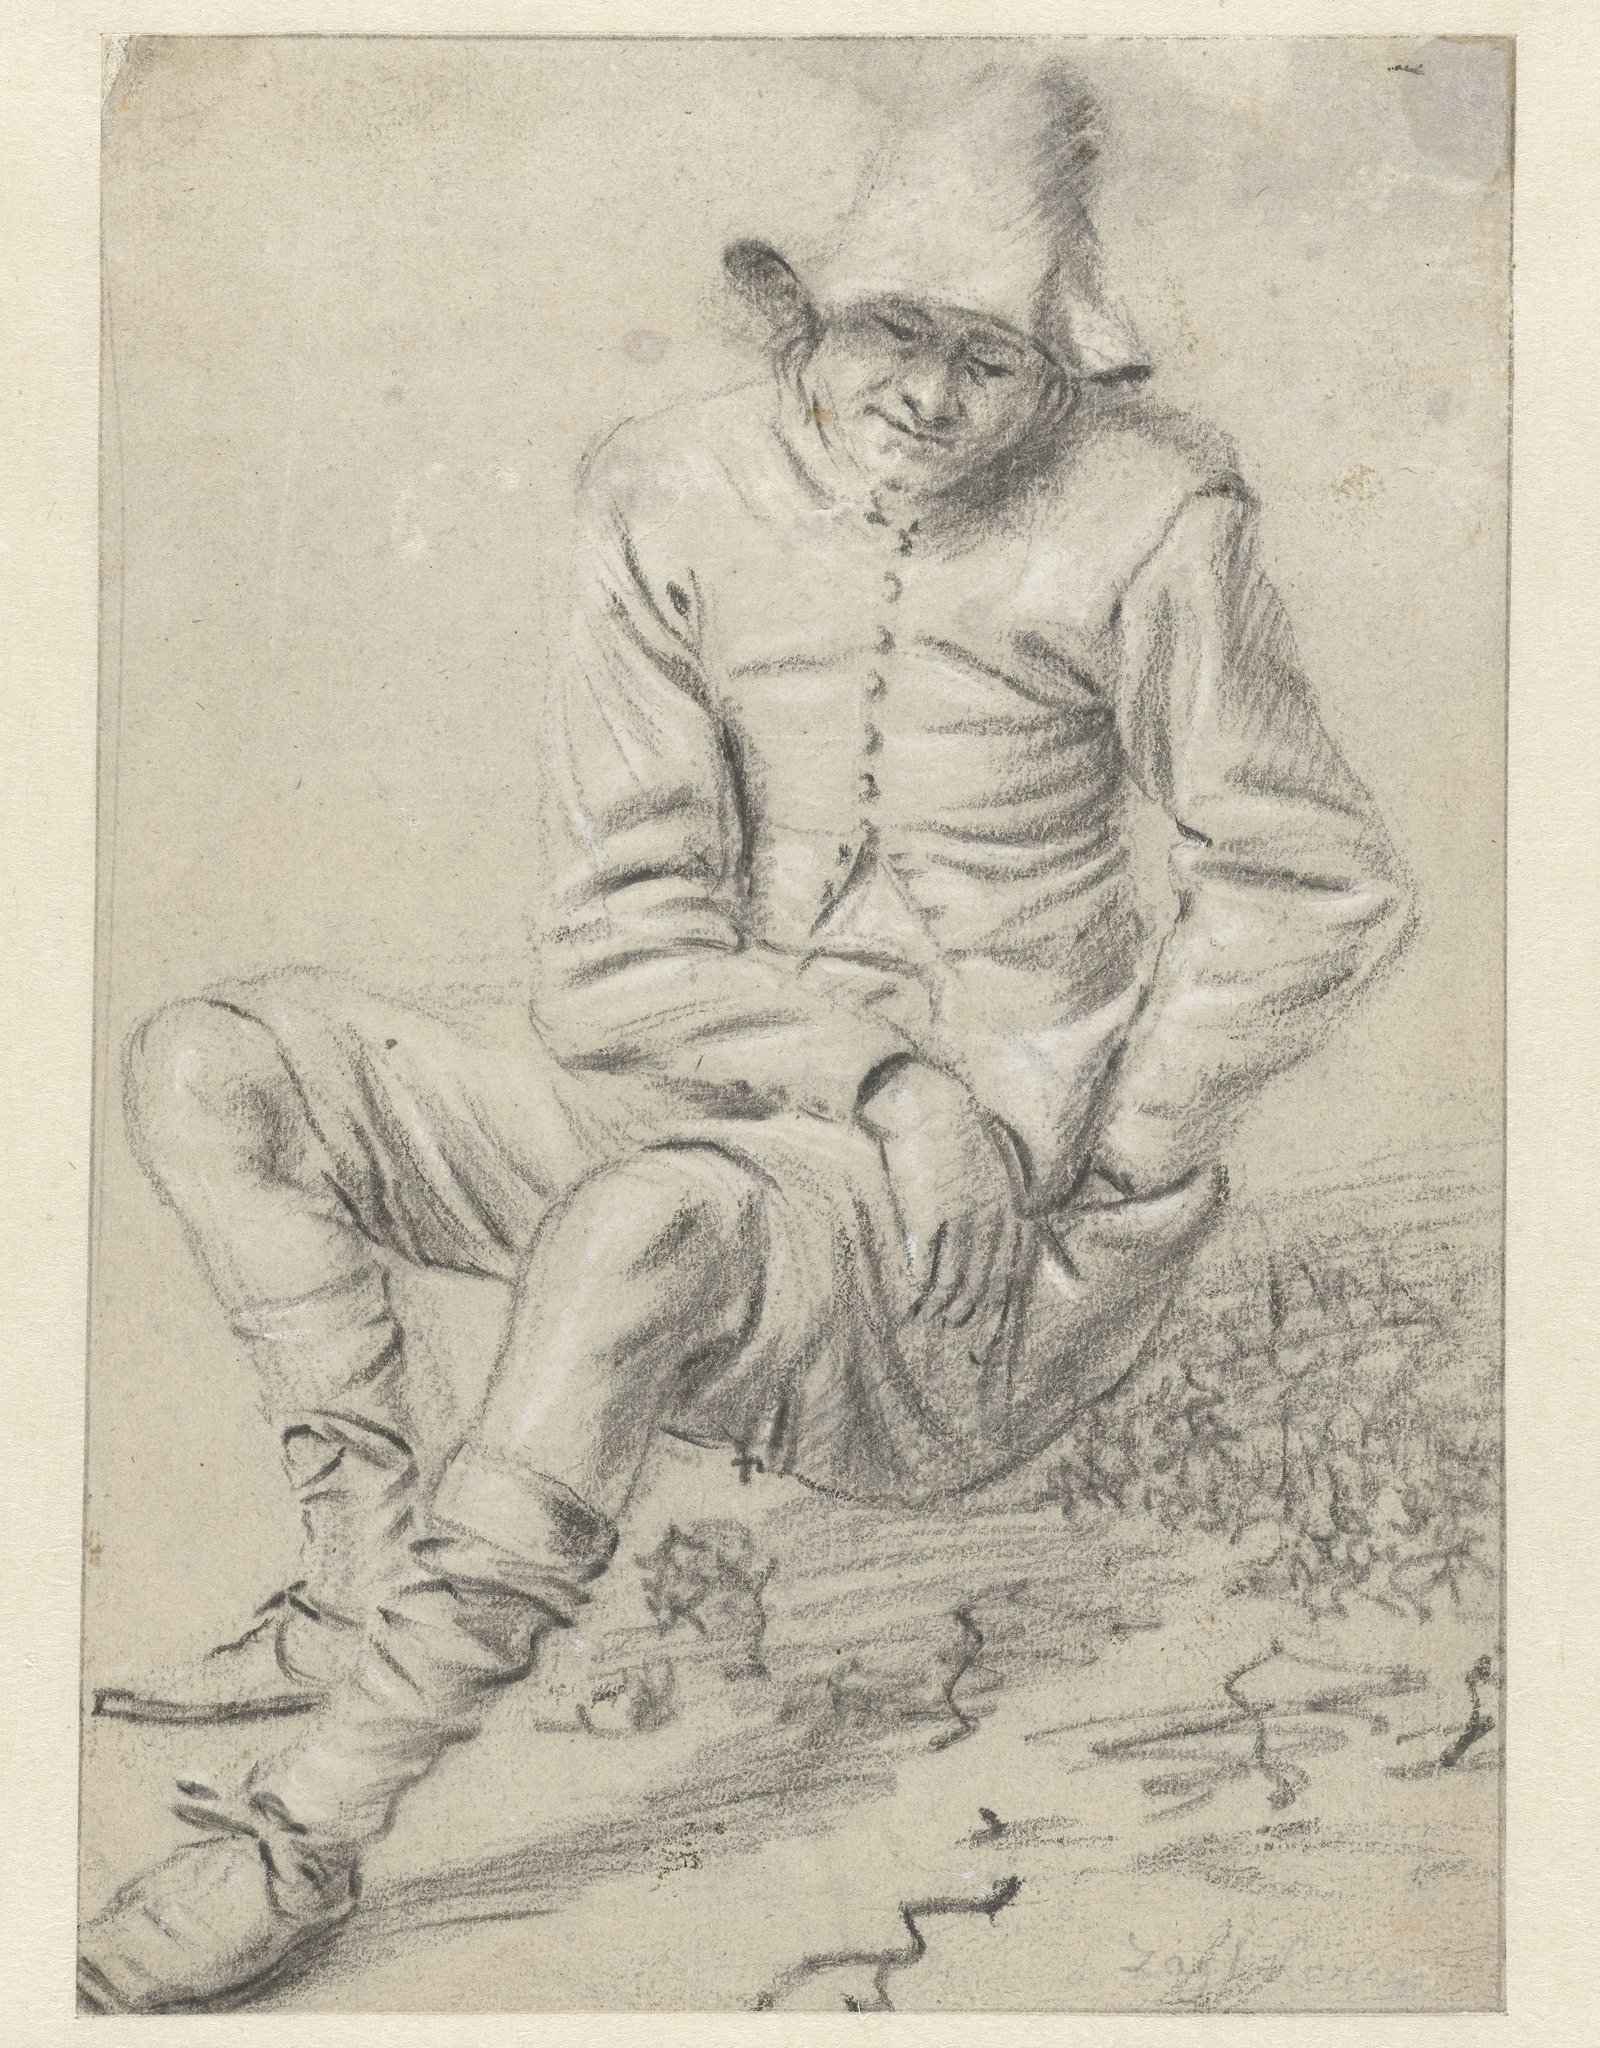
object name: drawing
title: Man die op de grond zit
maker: Anonymous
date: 1600-1699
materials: chalk, paper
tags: sitting figure